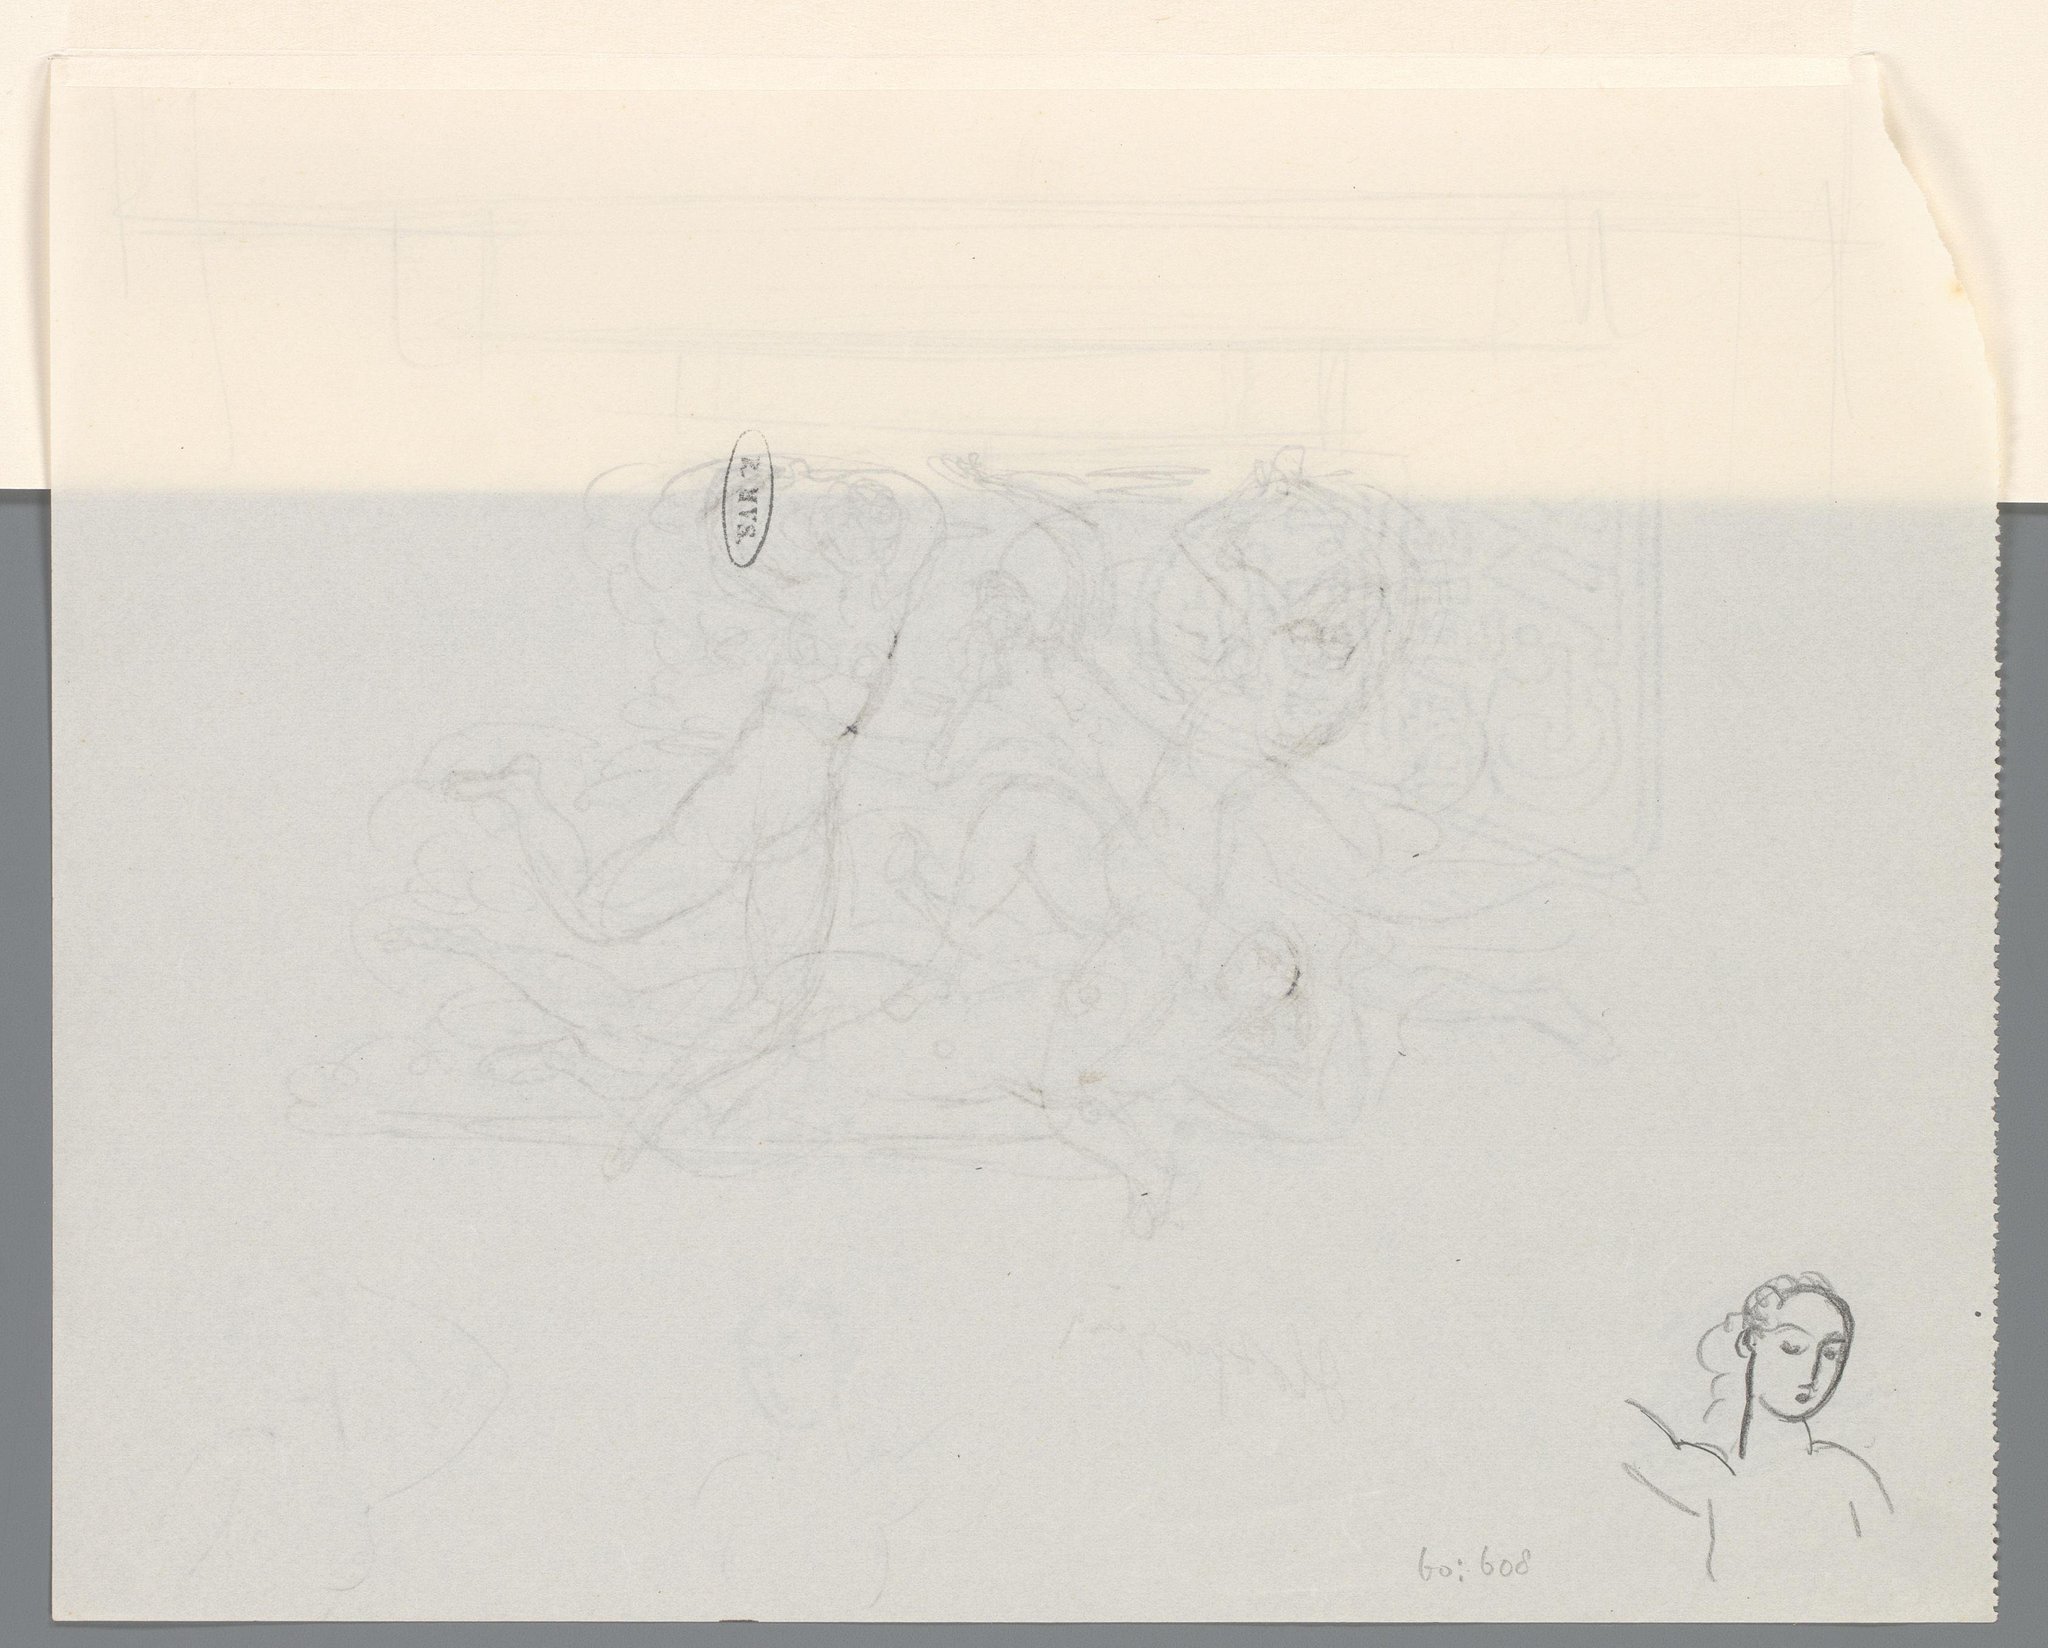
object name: drawing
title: Studieblad met vrouwenhoofd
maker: leo gestel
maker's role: draughtsman, print maker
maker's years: 1881-1941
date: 1891-1941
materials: paper, pencil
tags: head (human) - aa - female human figure